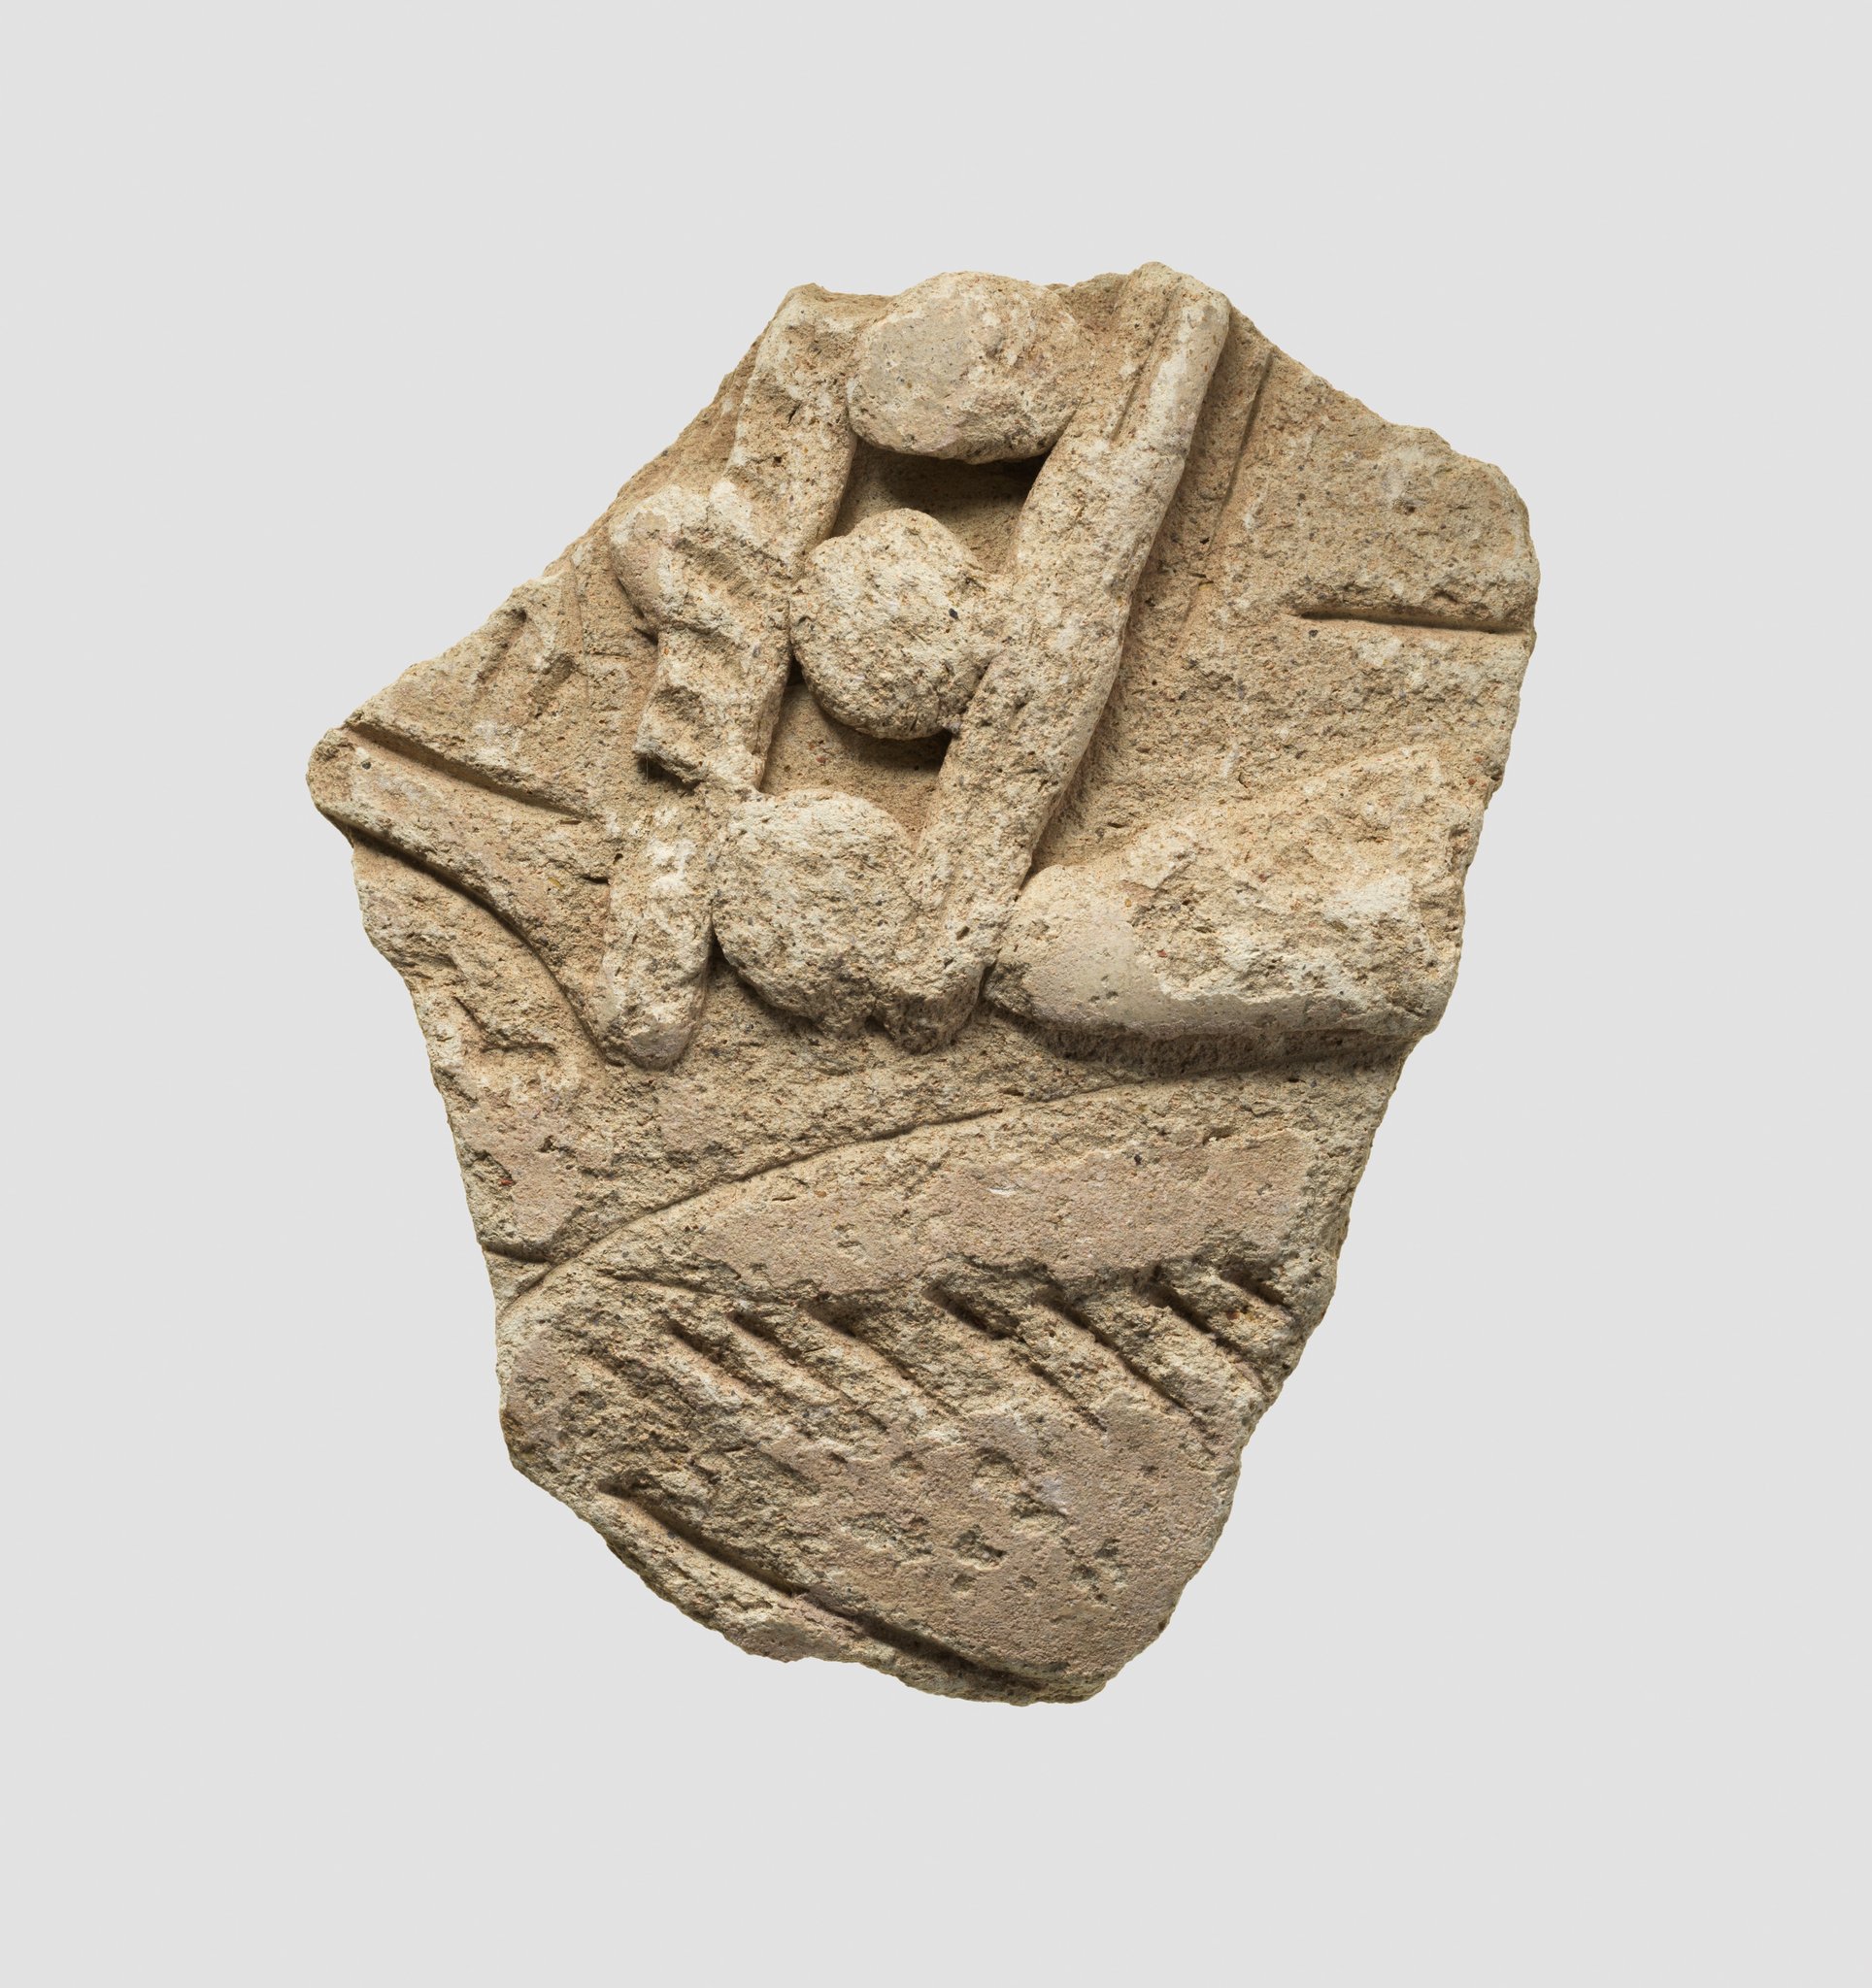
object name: sherd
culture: sasanian or islamic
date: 501-800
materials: ceramic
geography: mesopotamia